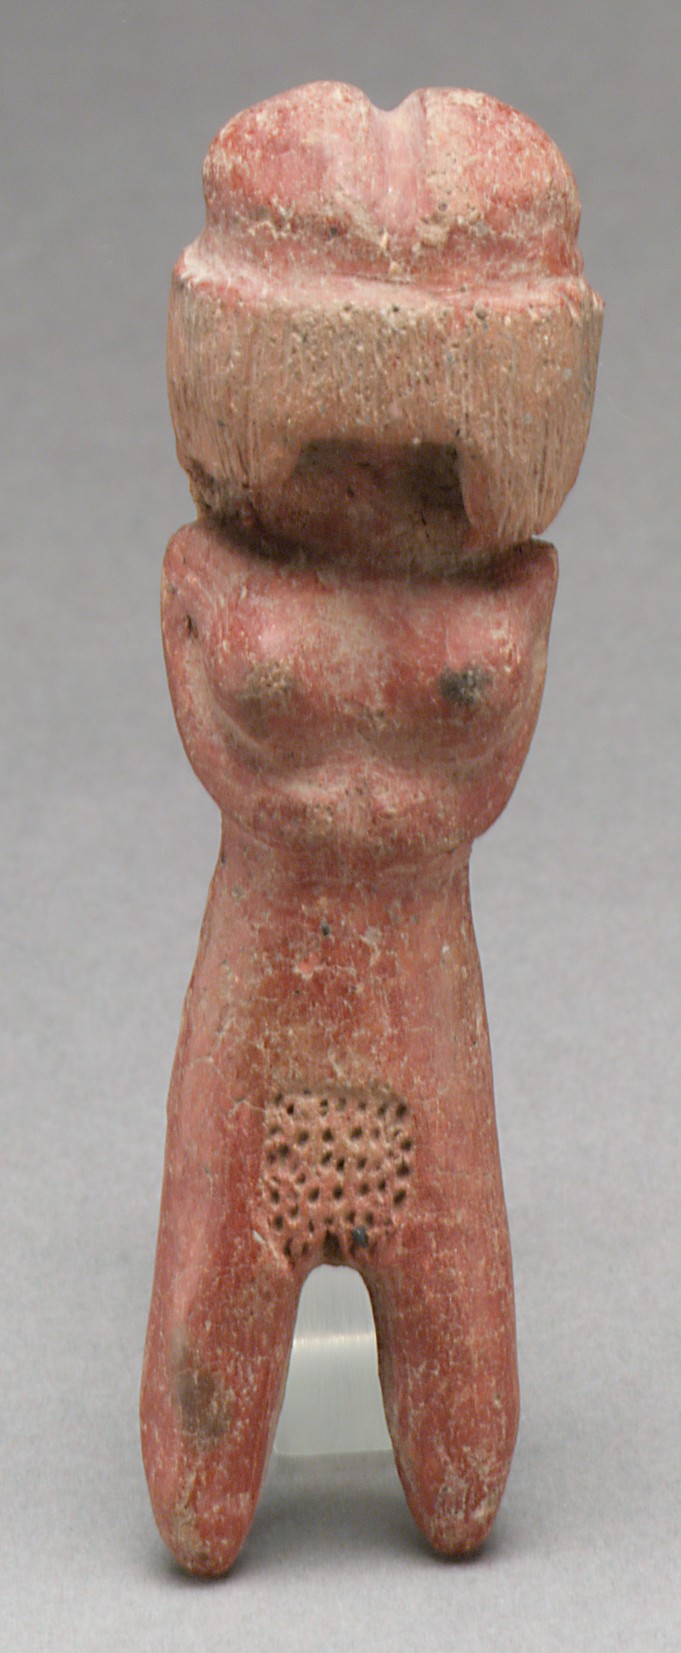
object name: female figure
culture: valdivia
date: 2333-2001 BCE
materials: ceramic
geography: ecuador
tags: female nudes